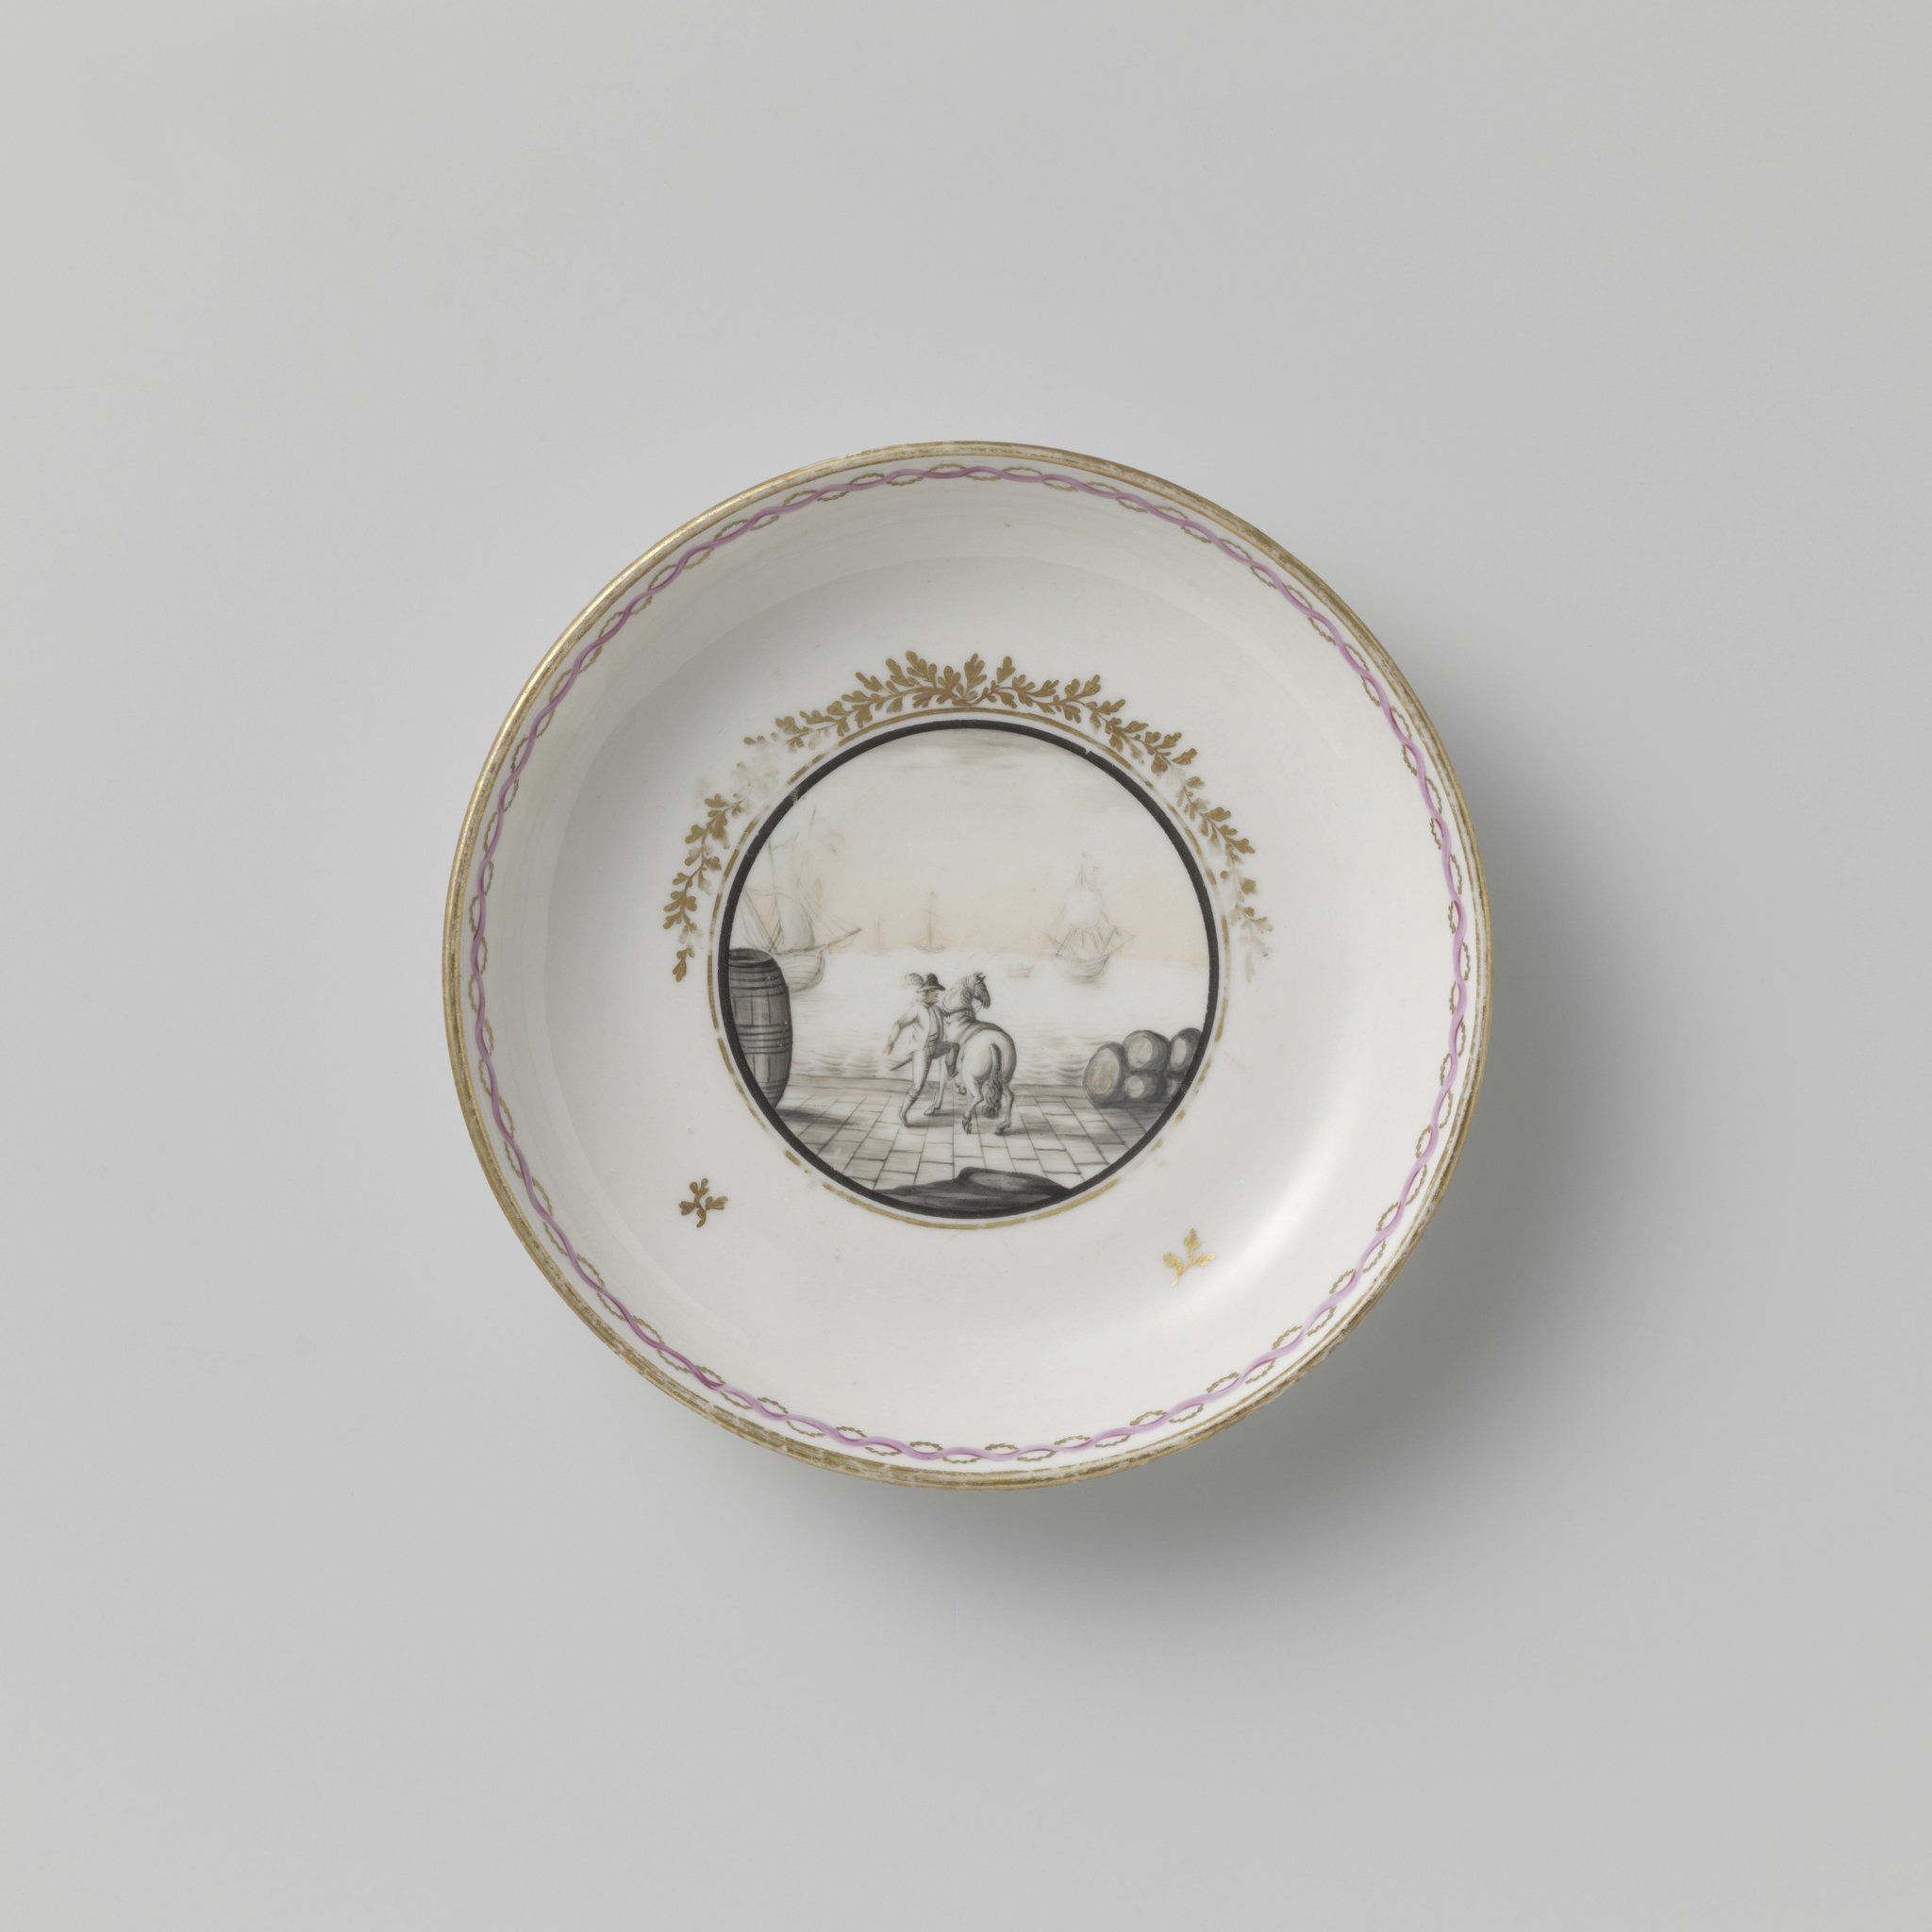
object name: platter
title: Saucer with a man on the coast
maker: Anonymous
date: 1790-1800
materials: glaze, gold, paint, porcelain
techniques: firing, forming, gilding, turning, vitrification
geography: europe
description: Schotel van soft-paste porselein (pâte tendre), beschilderd op het glazuur in rood, roze, zwart en goud. Op het plat een medaillon met daarin een man aan de kust. Hij staat op het punt zijn paard te bestijgen. Op de achtergrond enkele boten op het water. Boven het medaillon een guirlande en eronder twee bloemtakken. Op de binnenrand een golvende band van een lint en een bladrank die elkaar kruisen.